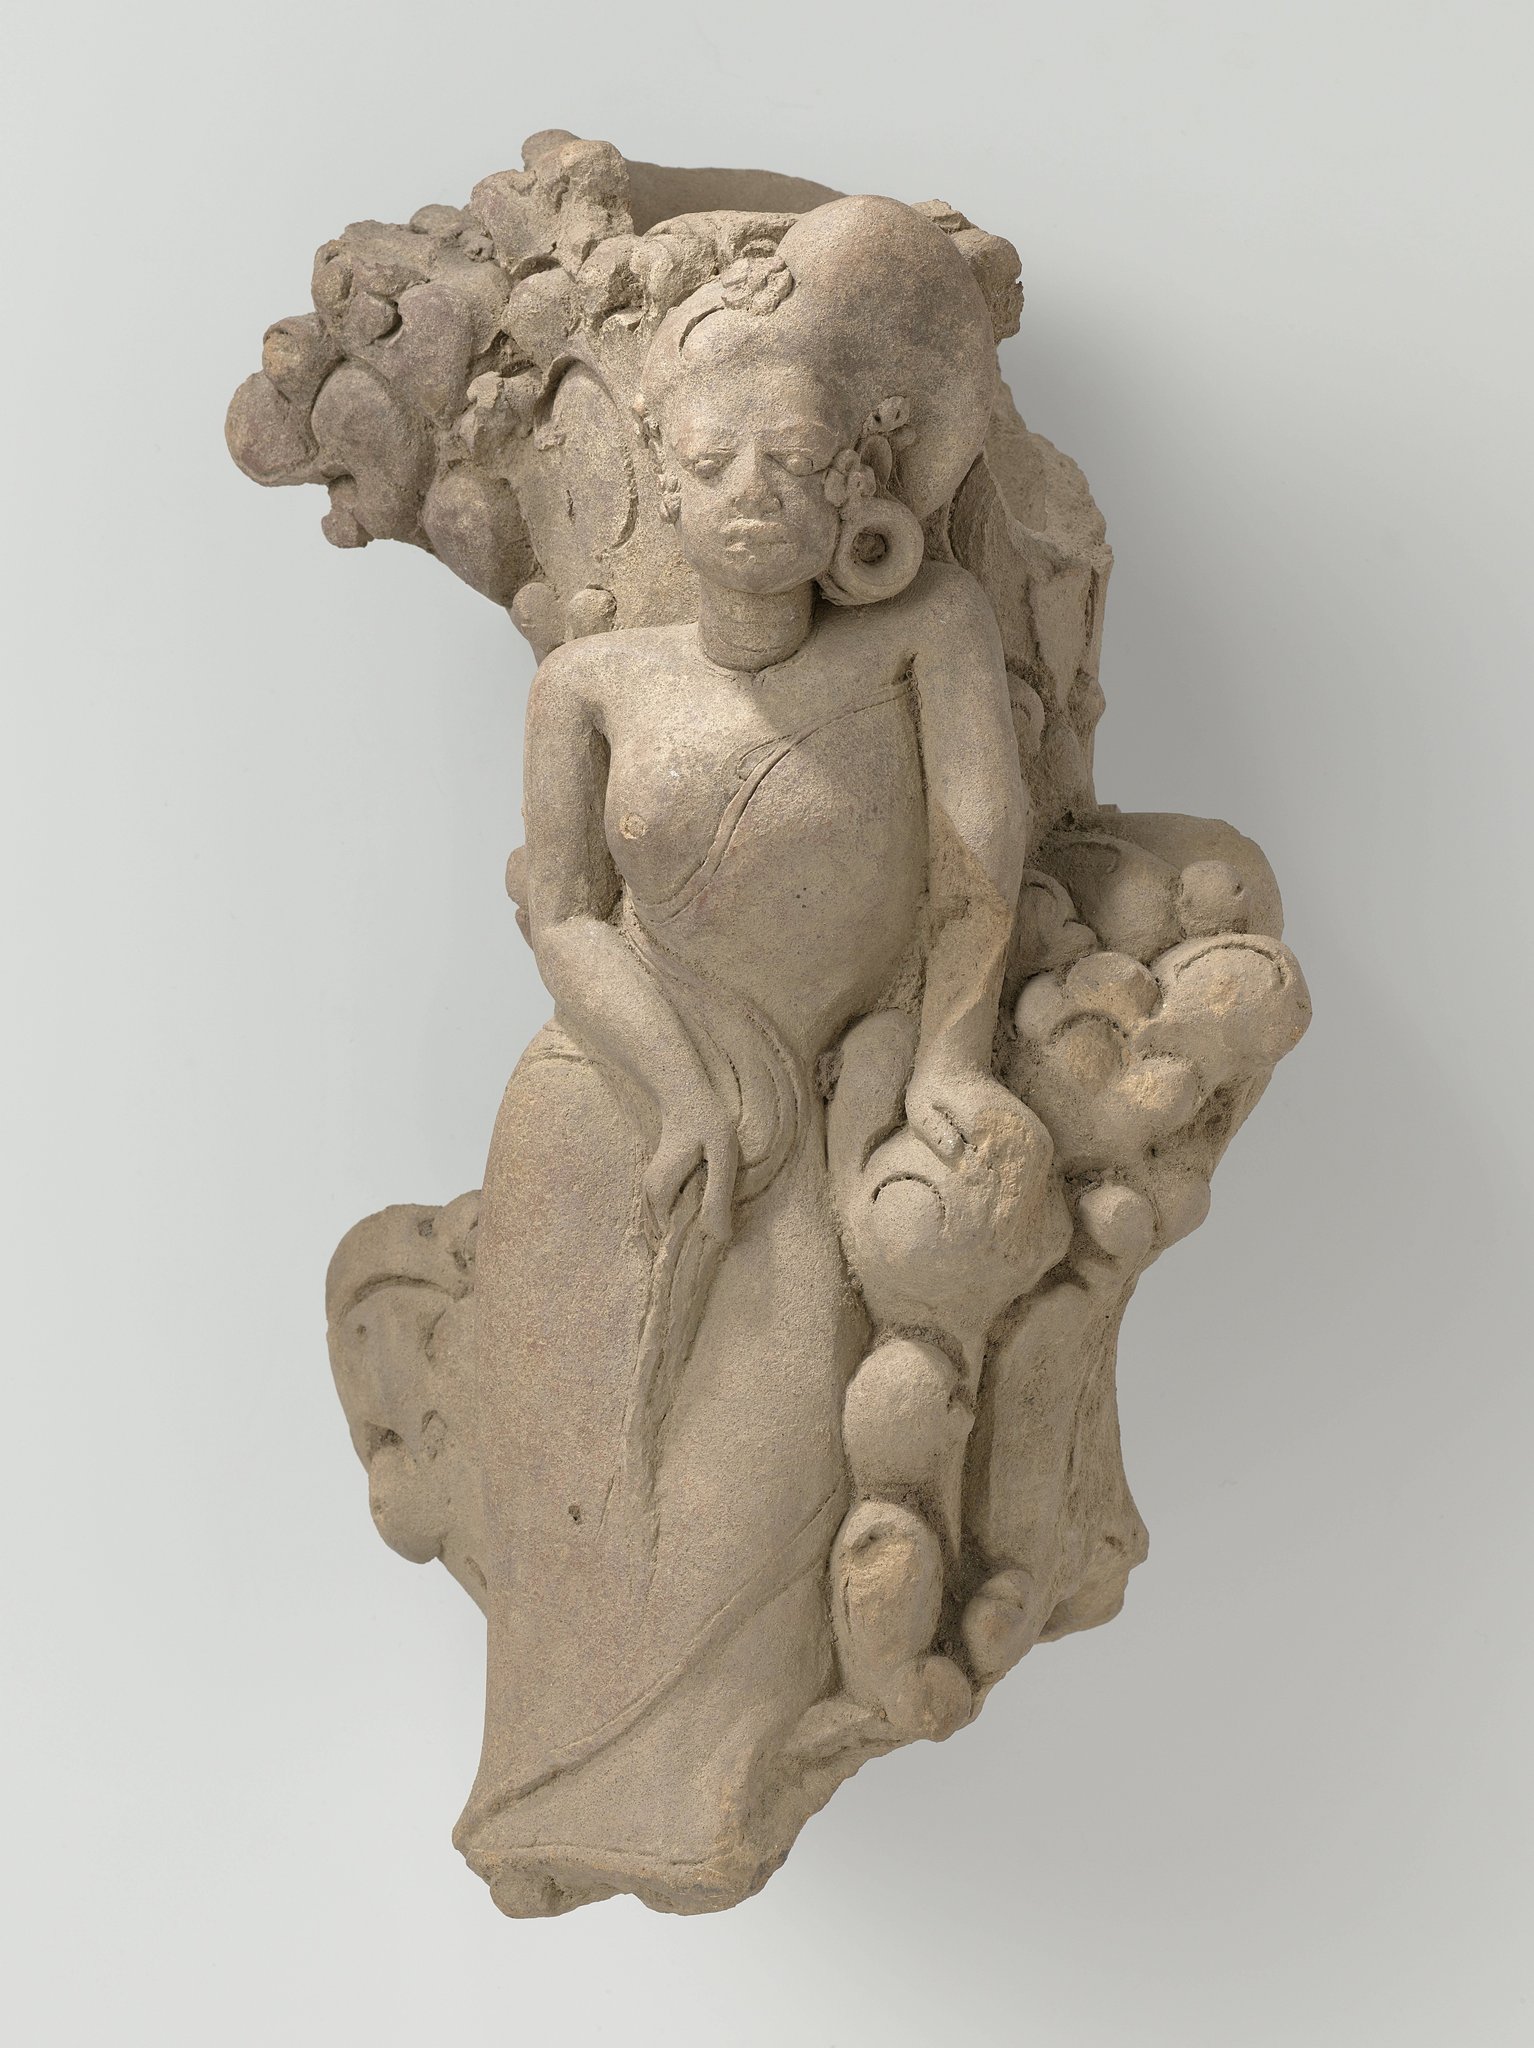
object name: sculpture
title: Heavenly beauty, pillar decoration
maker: Anonymous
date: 1300-1500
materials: terracotta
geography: east java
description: In contrast to Javanese sacred figures made of stone, which tend to be rigid and formal, their terracotta counterparts are often naturalistic and three-dimensional. This heavenly beauty with large ear ornaments once adorned the base of a wooden pillar in a Javanese house or in a pendopo, an open pavilion supported by columns.